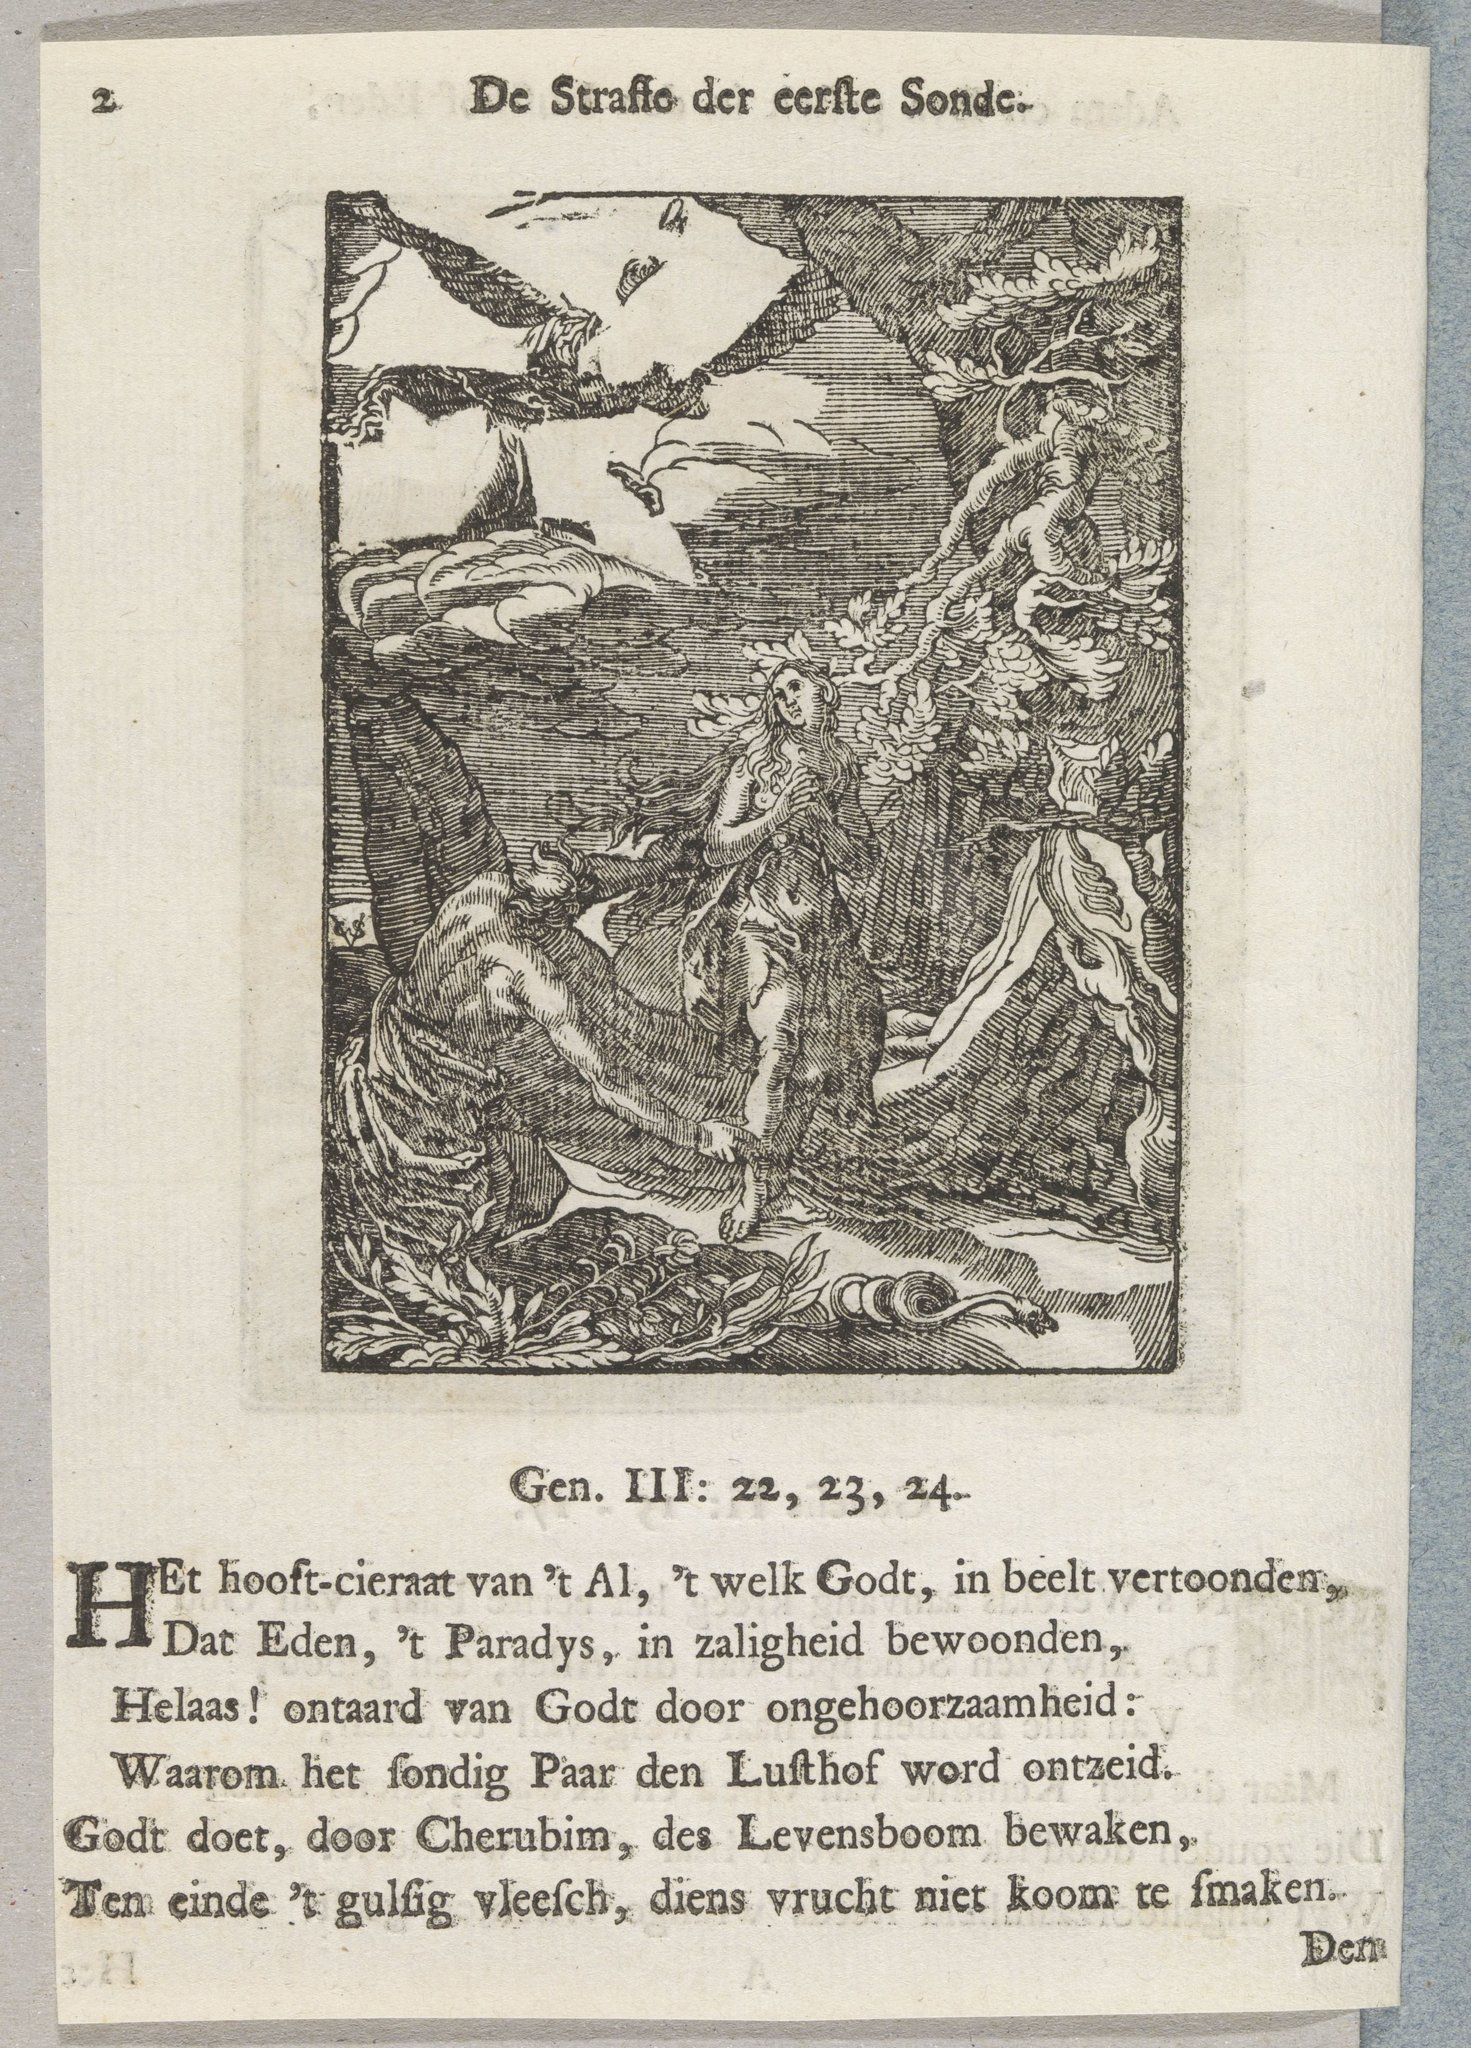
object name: album leaf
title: Expulsion from Paradise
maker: jan klooster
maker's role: bookseller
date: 1740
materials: paper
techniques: letterpress printing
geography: amsterdam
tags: expulsion of adam and eve from paradise (genesis 3:22-24)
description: Van deze prenten zijn twee staten bekend. Op deze tweede staat is de afbeelding van de Engel van de Heer deels van de voorstelling verwijderd. De prent is afkomstig uit: Bybels Lusthof. Amsterdam, J. Klooster, 1740. De prent werd gemaakt voor de uitgaven van P.J. Paets uit Amsterdam. Ze komt in ieder geval voor in: Bibels Tresoor ofte der zielen lusthof. Amsterdam, P.J. Paets, 1646 en Biblia Sacra. Amsterdam, P.J. Paets, 1657. Mogelijk staat ze ook in: Historien ende Prophetien. [Amsterdam], P.J. Paets, 1645.